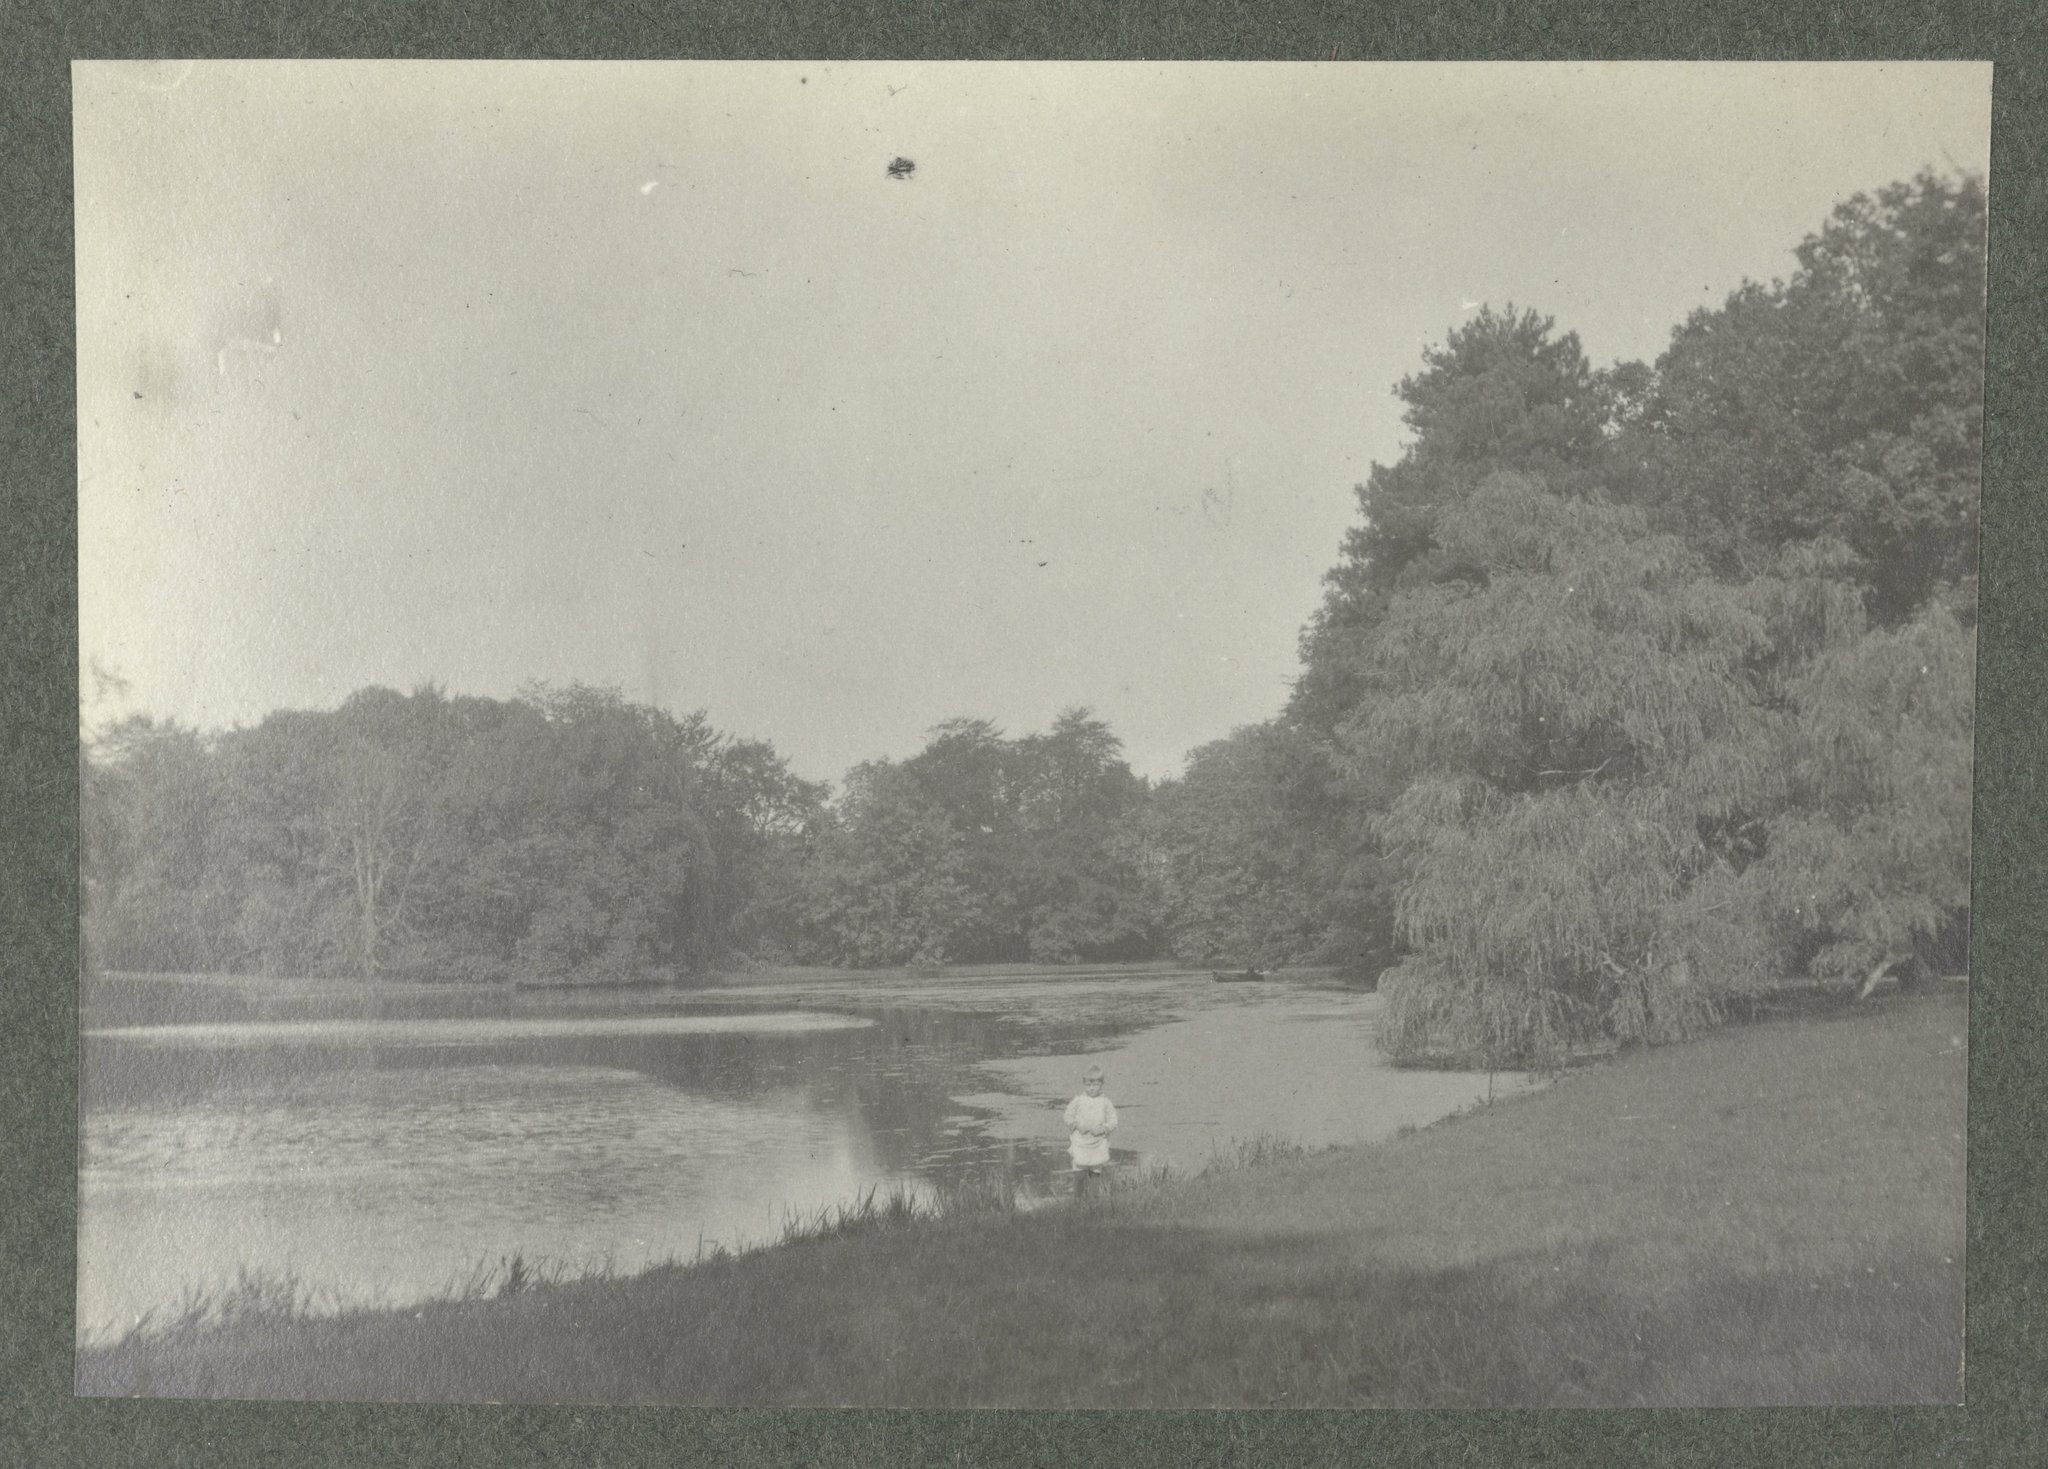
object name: photograph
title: Kindje bij het water op landgoed De Pauw in Wassenaar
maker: geldolph adriaan kessler (dolph)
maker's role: fotograaf, industrieel, voetballer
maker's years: 1884-1945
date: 1913-1920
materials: paper, photographic support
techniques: gelatin silver print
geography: wassenaar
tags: huize de paauw